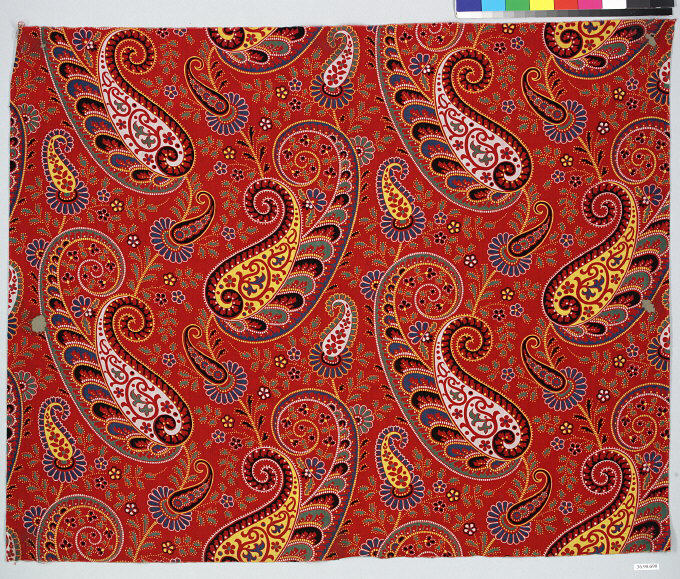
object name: piece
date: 1867-1900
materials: cotton